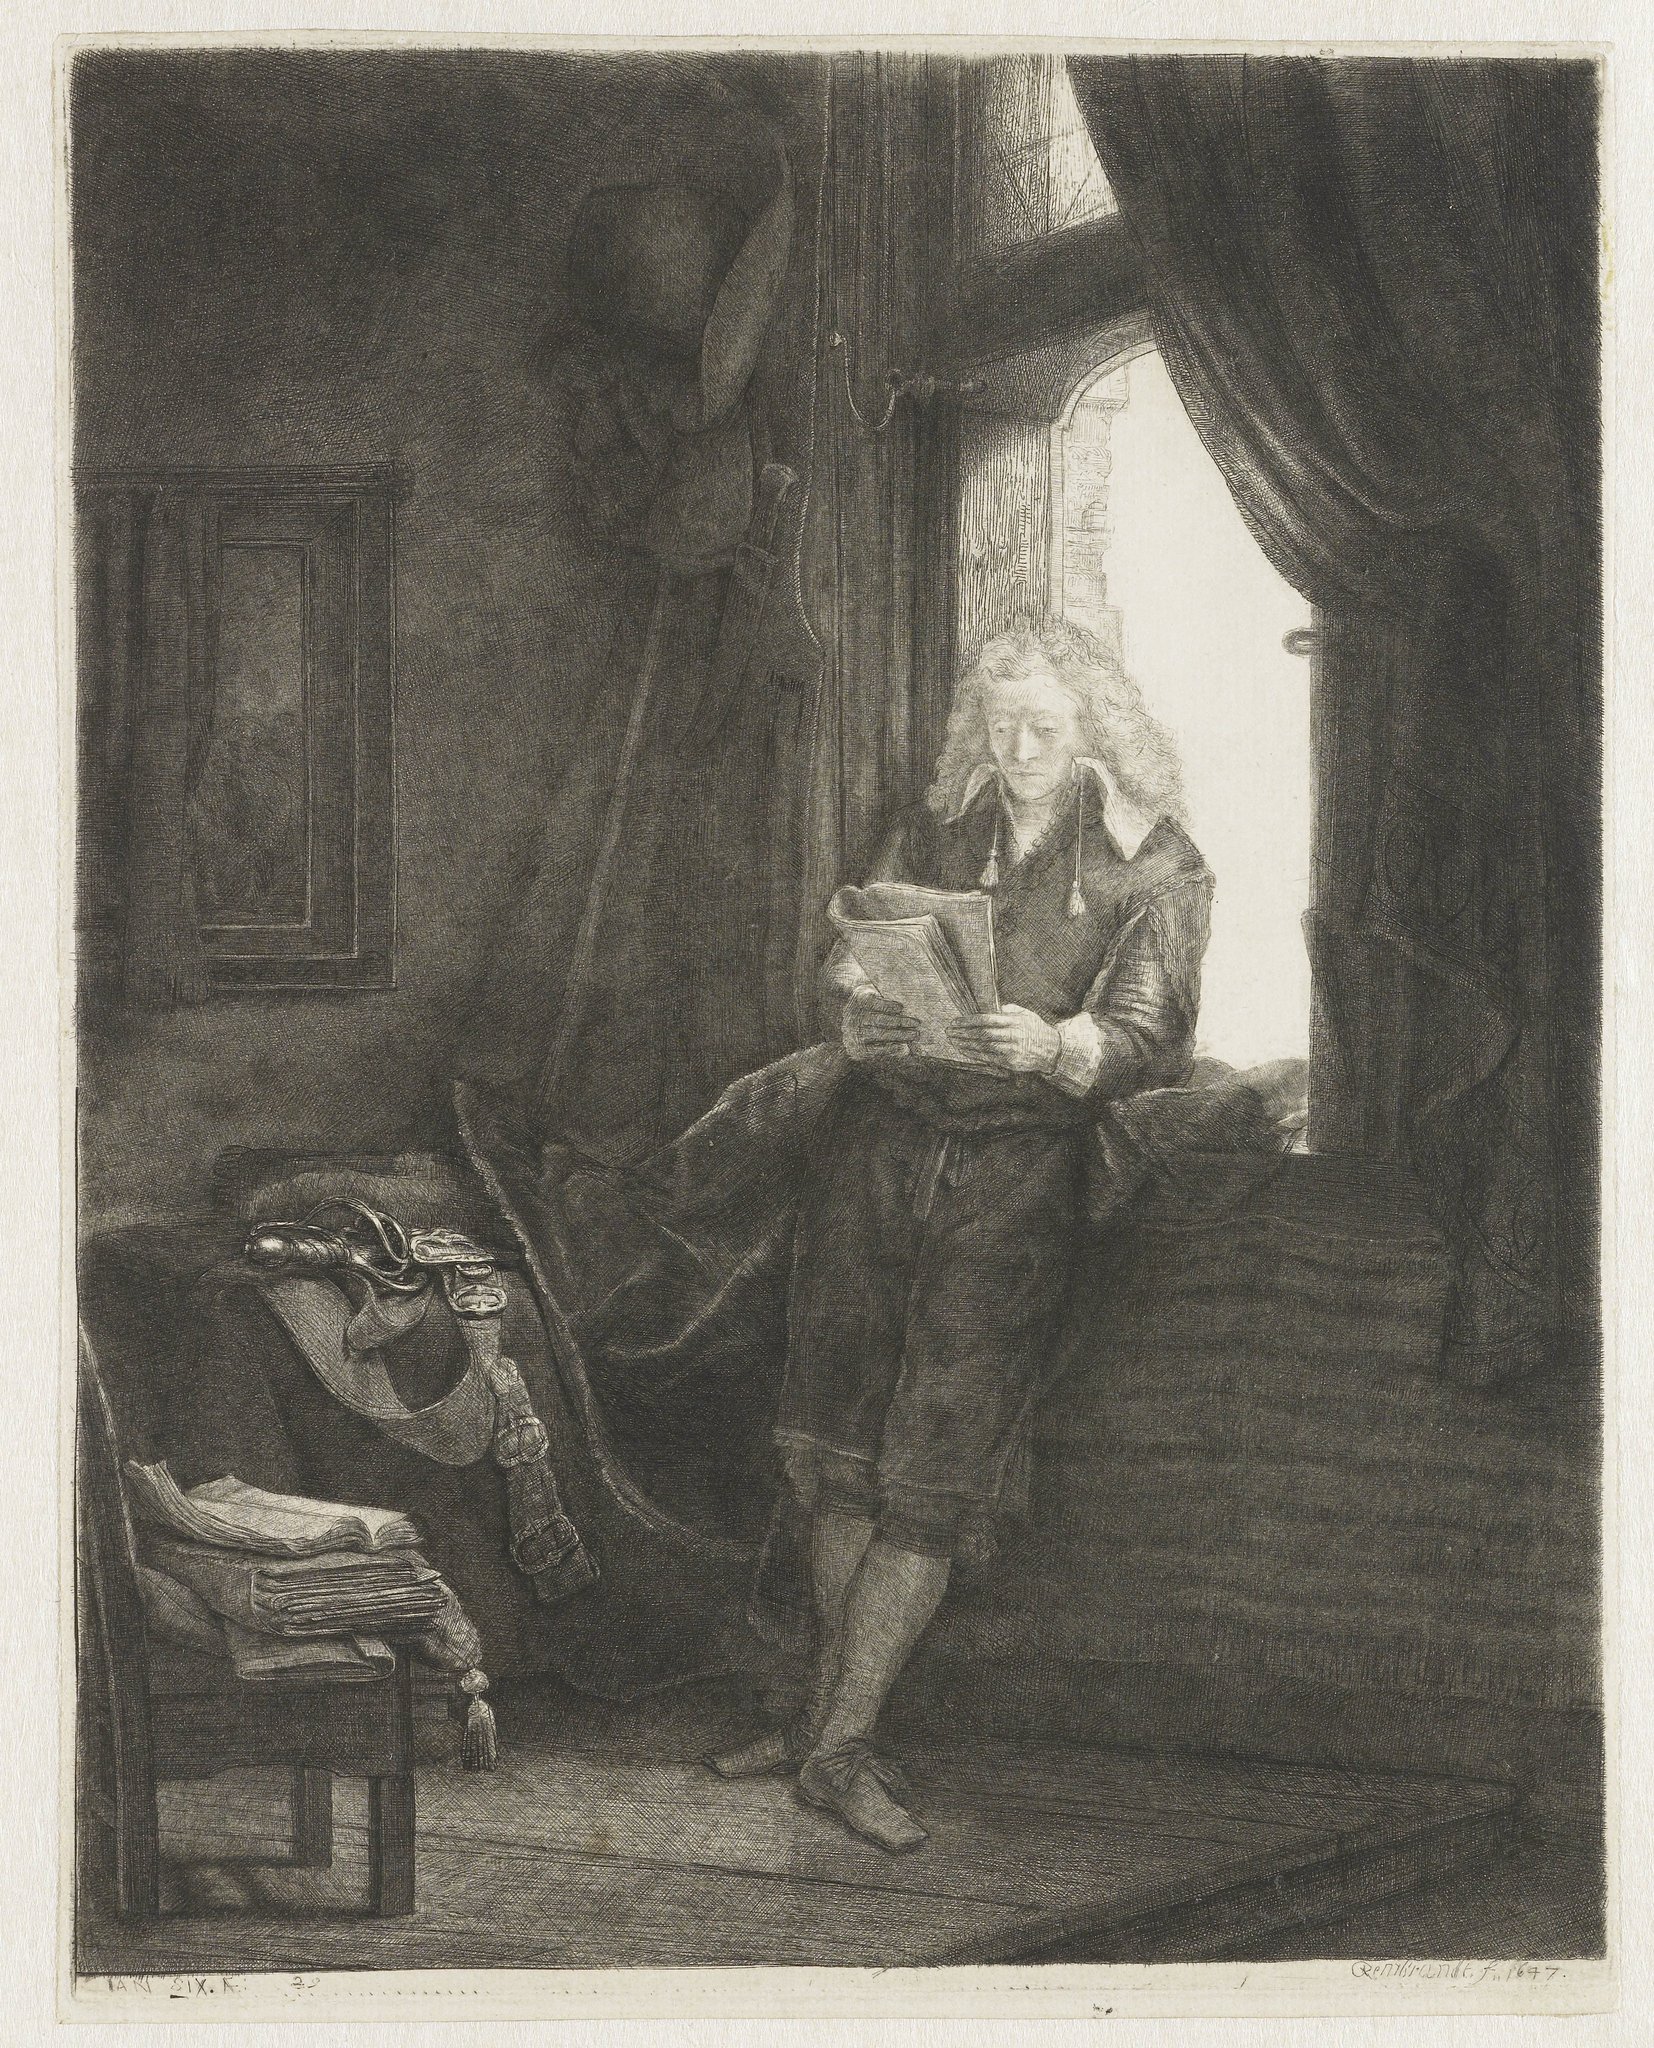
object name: print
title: Jan Six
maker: rembrandt van rijn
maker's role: draughtsman, painter, print maker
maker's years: 1606-1669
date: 1647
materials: paper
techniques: drypoint, etching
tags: amsterdam, mayor, jan six (1618-1700)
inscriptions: signature and date: ‘Rembrandt. f.. 1647’, collector's mark: Lugt 2228 a, collector's mark: Lugt 788